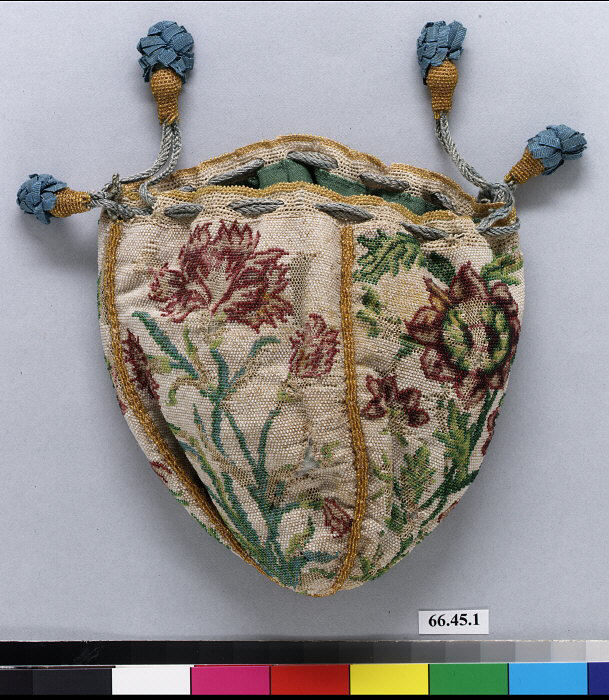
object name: purse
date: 1701-1800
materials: glass, silk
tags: flowers